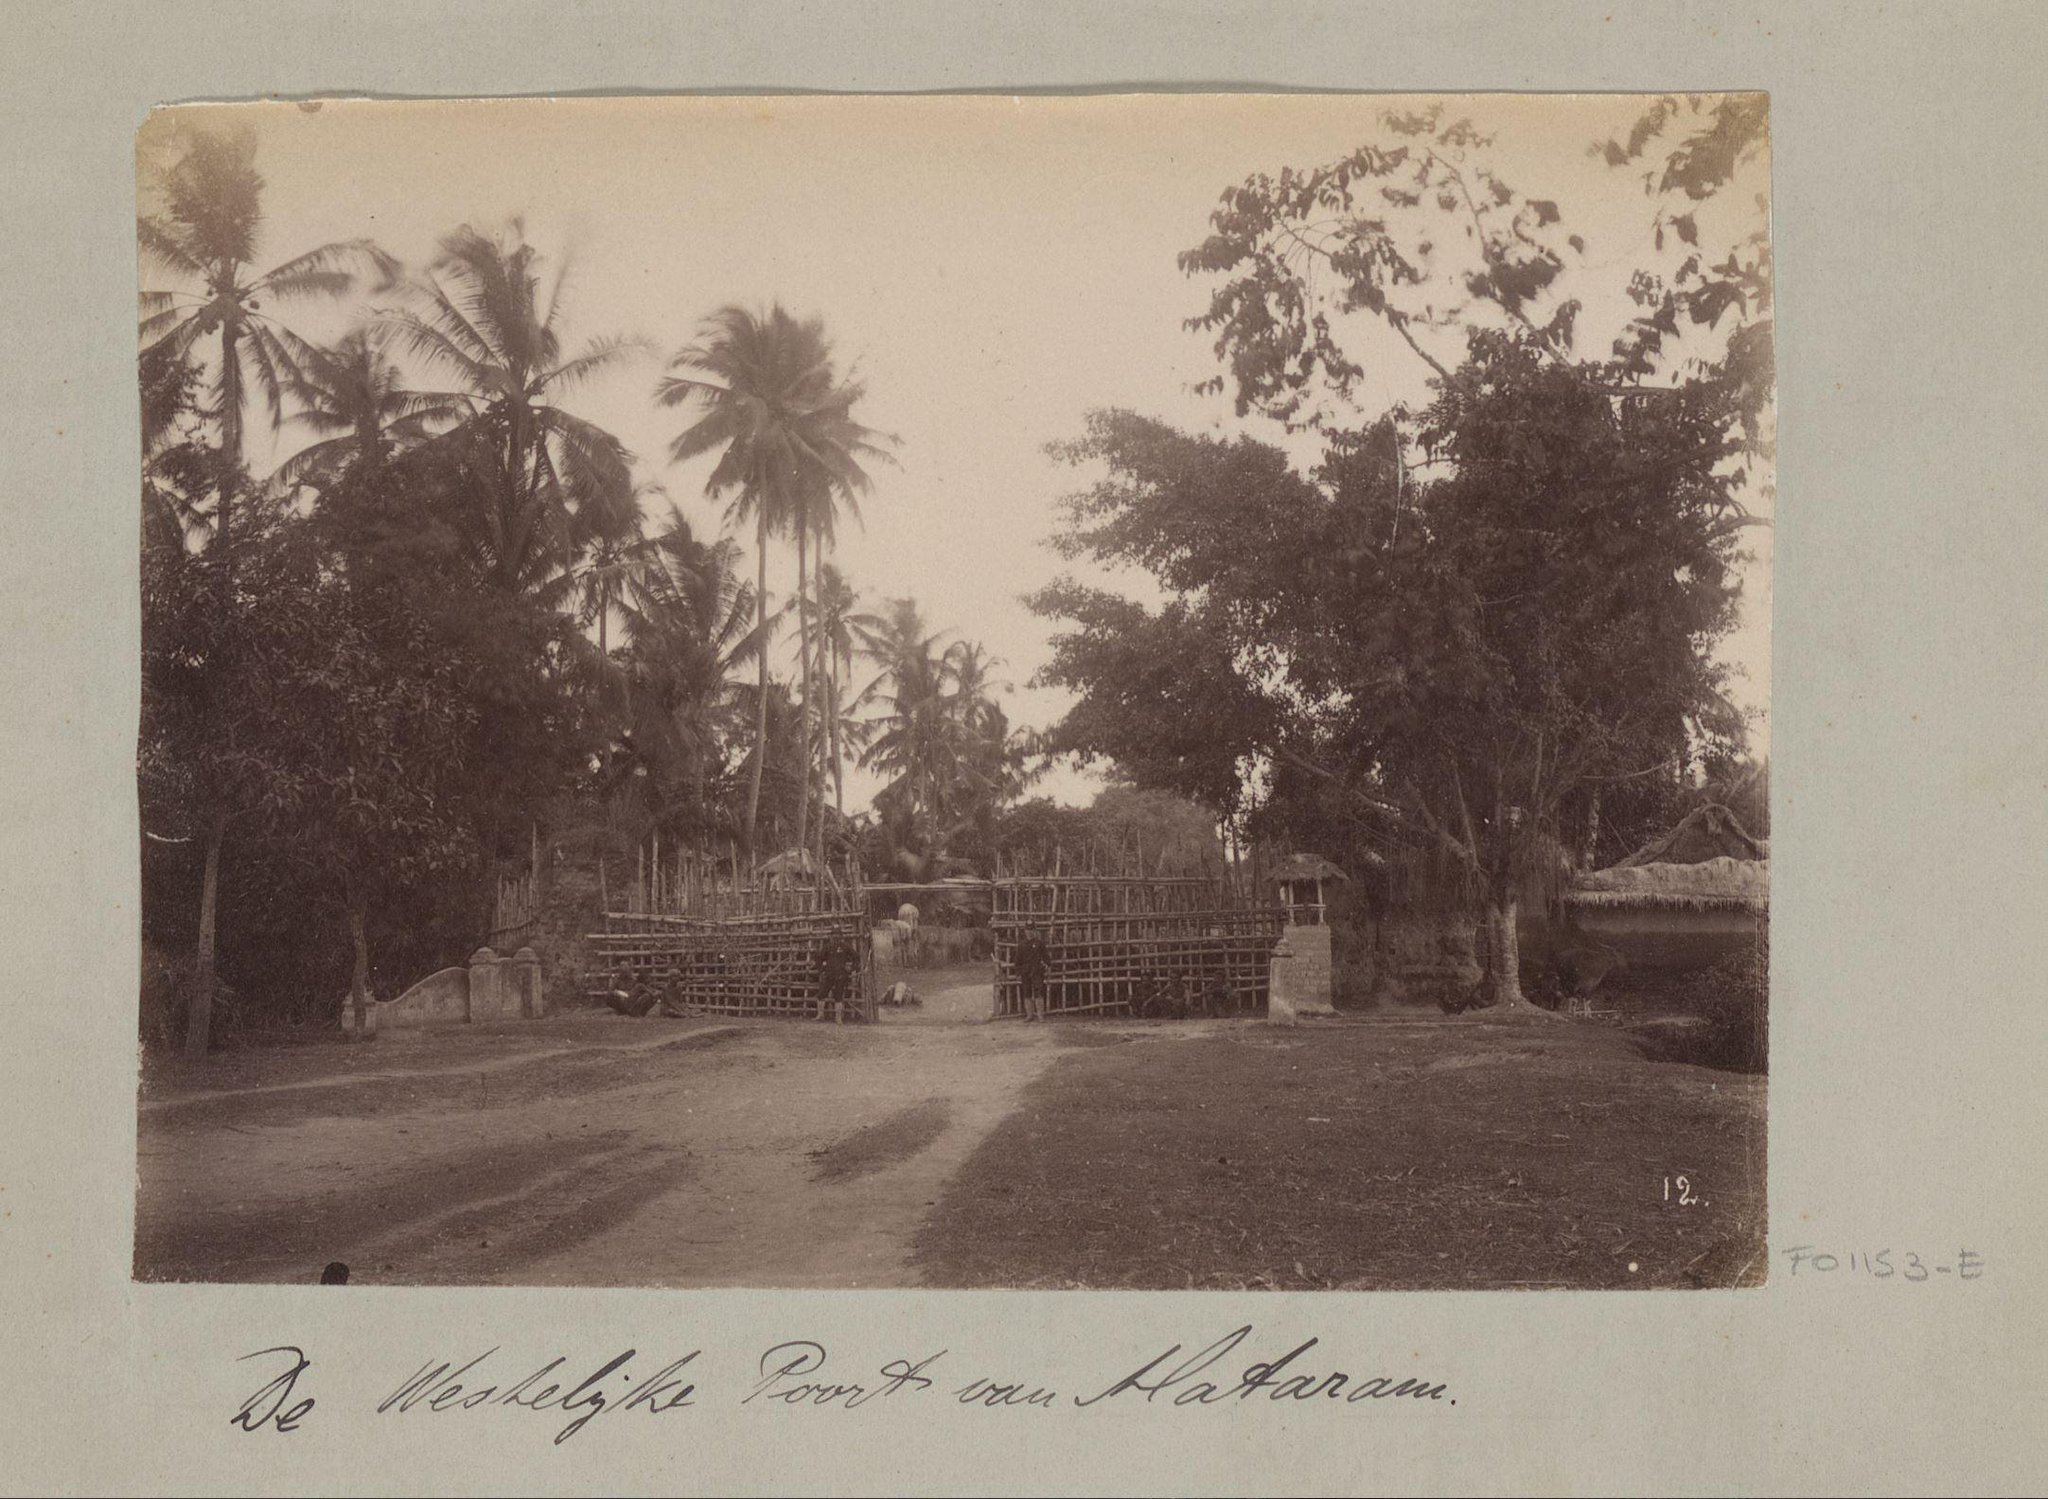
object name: album leaf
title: Westelijke poort van Mataram tijdens Lombok-expeditie 1894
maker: christiaan johan neeb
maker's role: arts, fotograaf, officier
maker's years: 1860-1925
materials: photographic support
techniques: albumen print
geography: lombok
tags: gate, entrance, dutch east indies, the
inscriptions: number: ‘12’